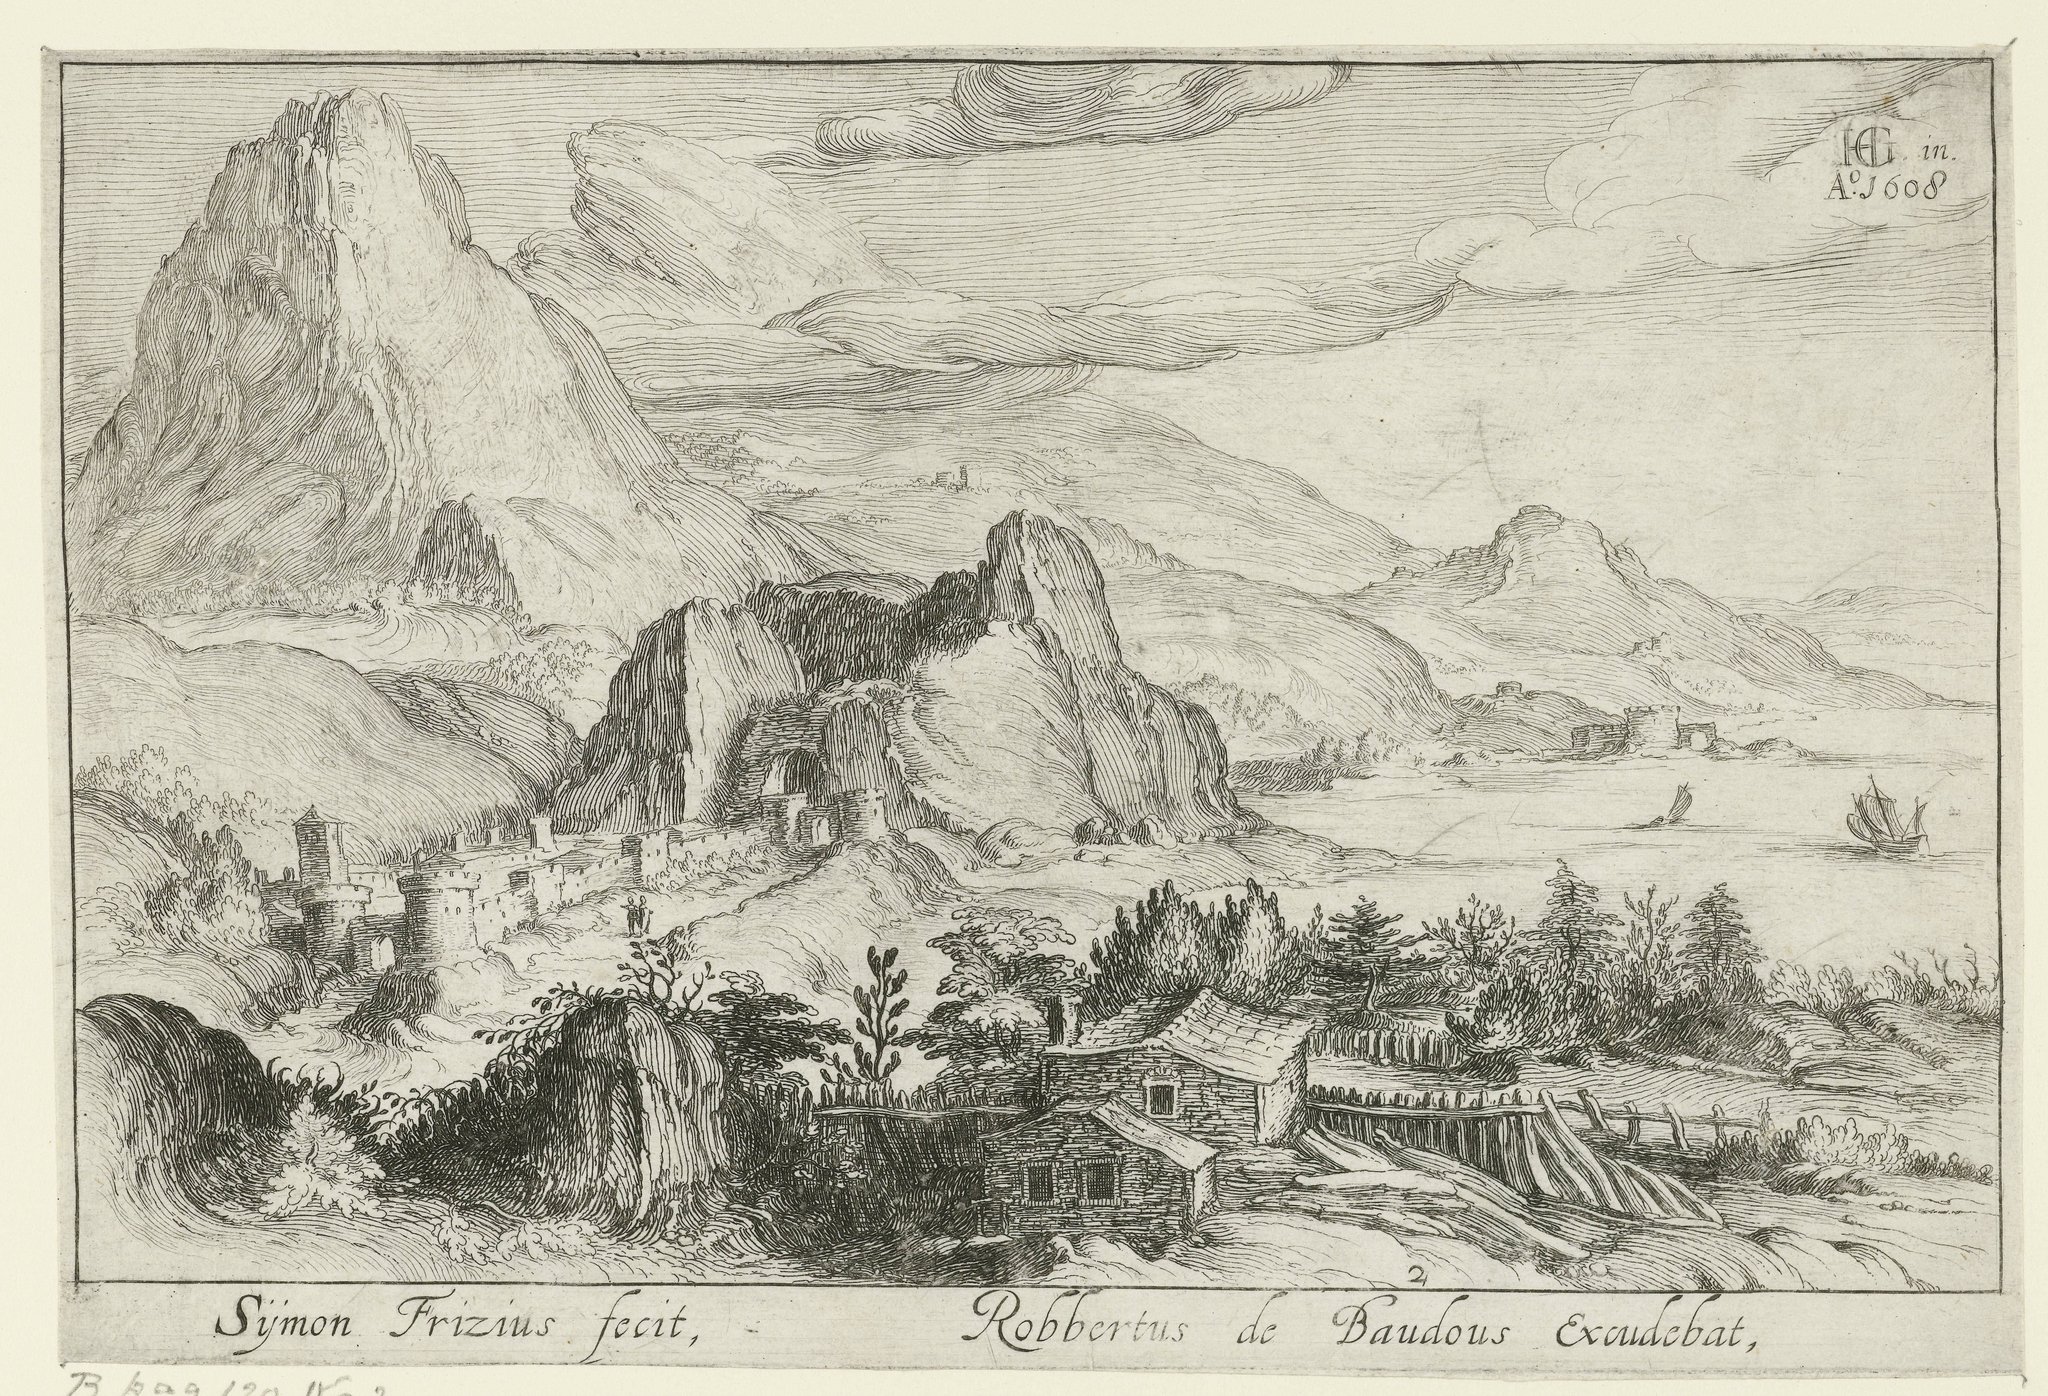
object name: print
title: Berglandschappen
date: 1608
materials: paper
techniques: etching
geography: haarlem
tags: landscapes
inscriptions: date